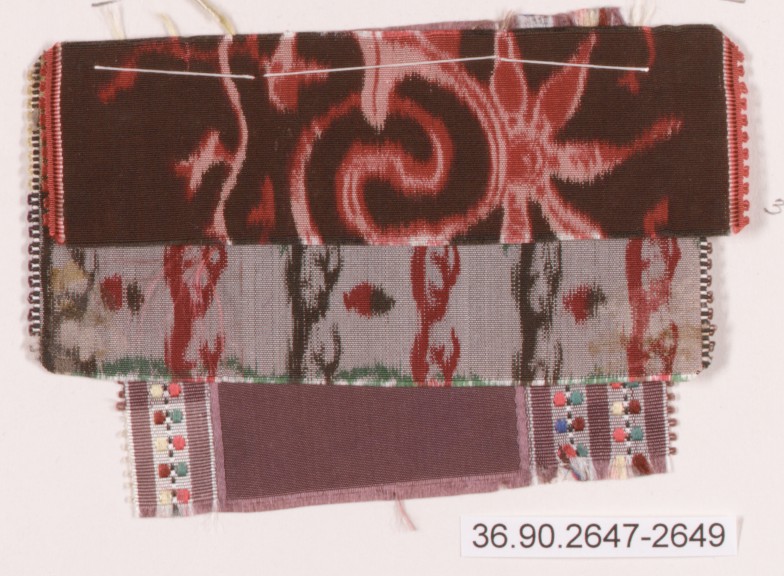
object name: ribbon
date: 1801-1900